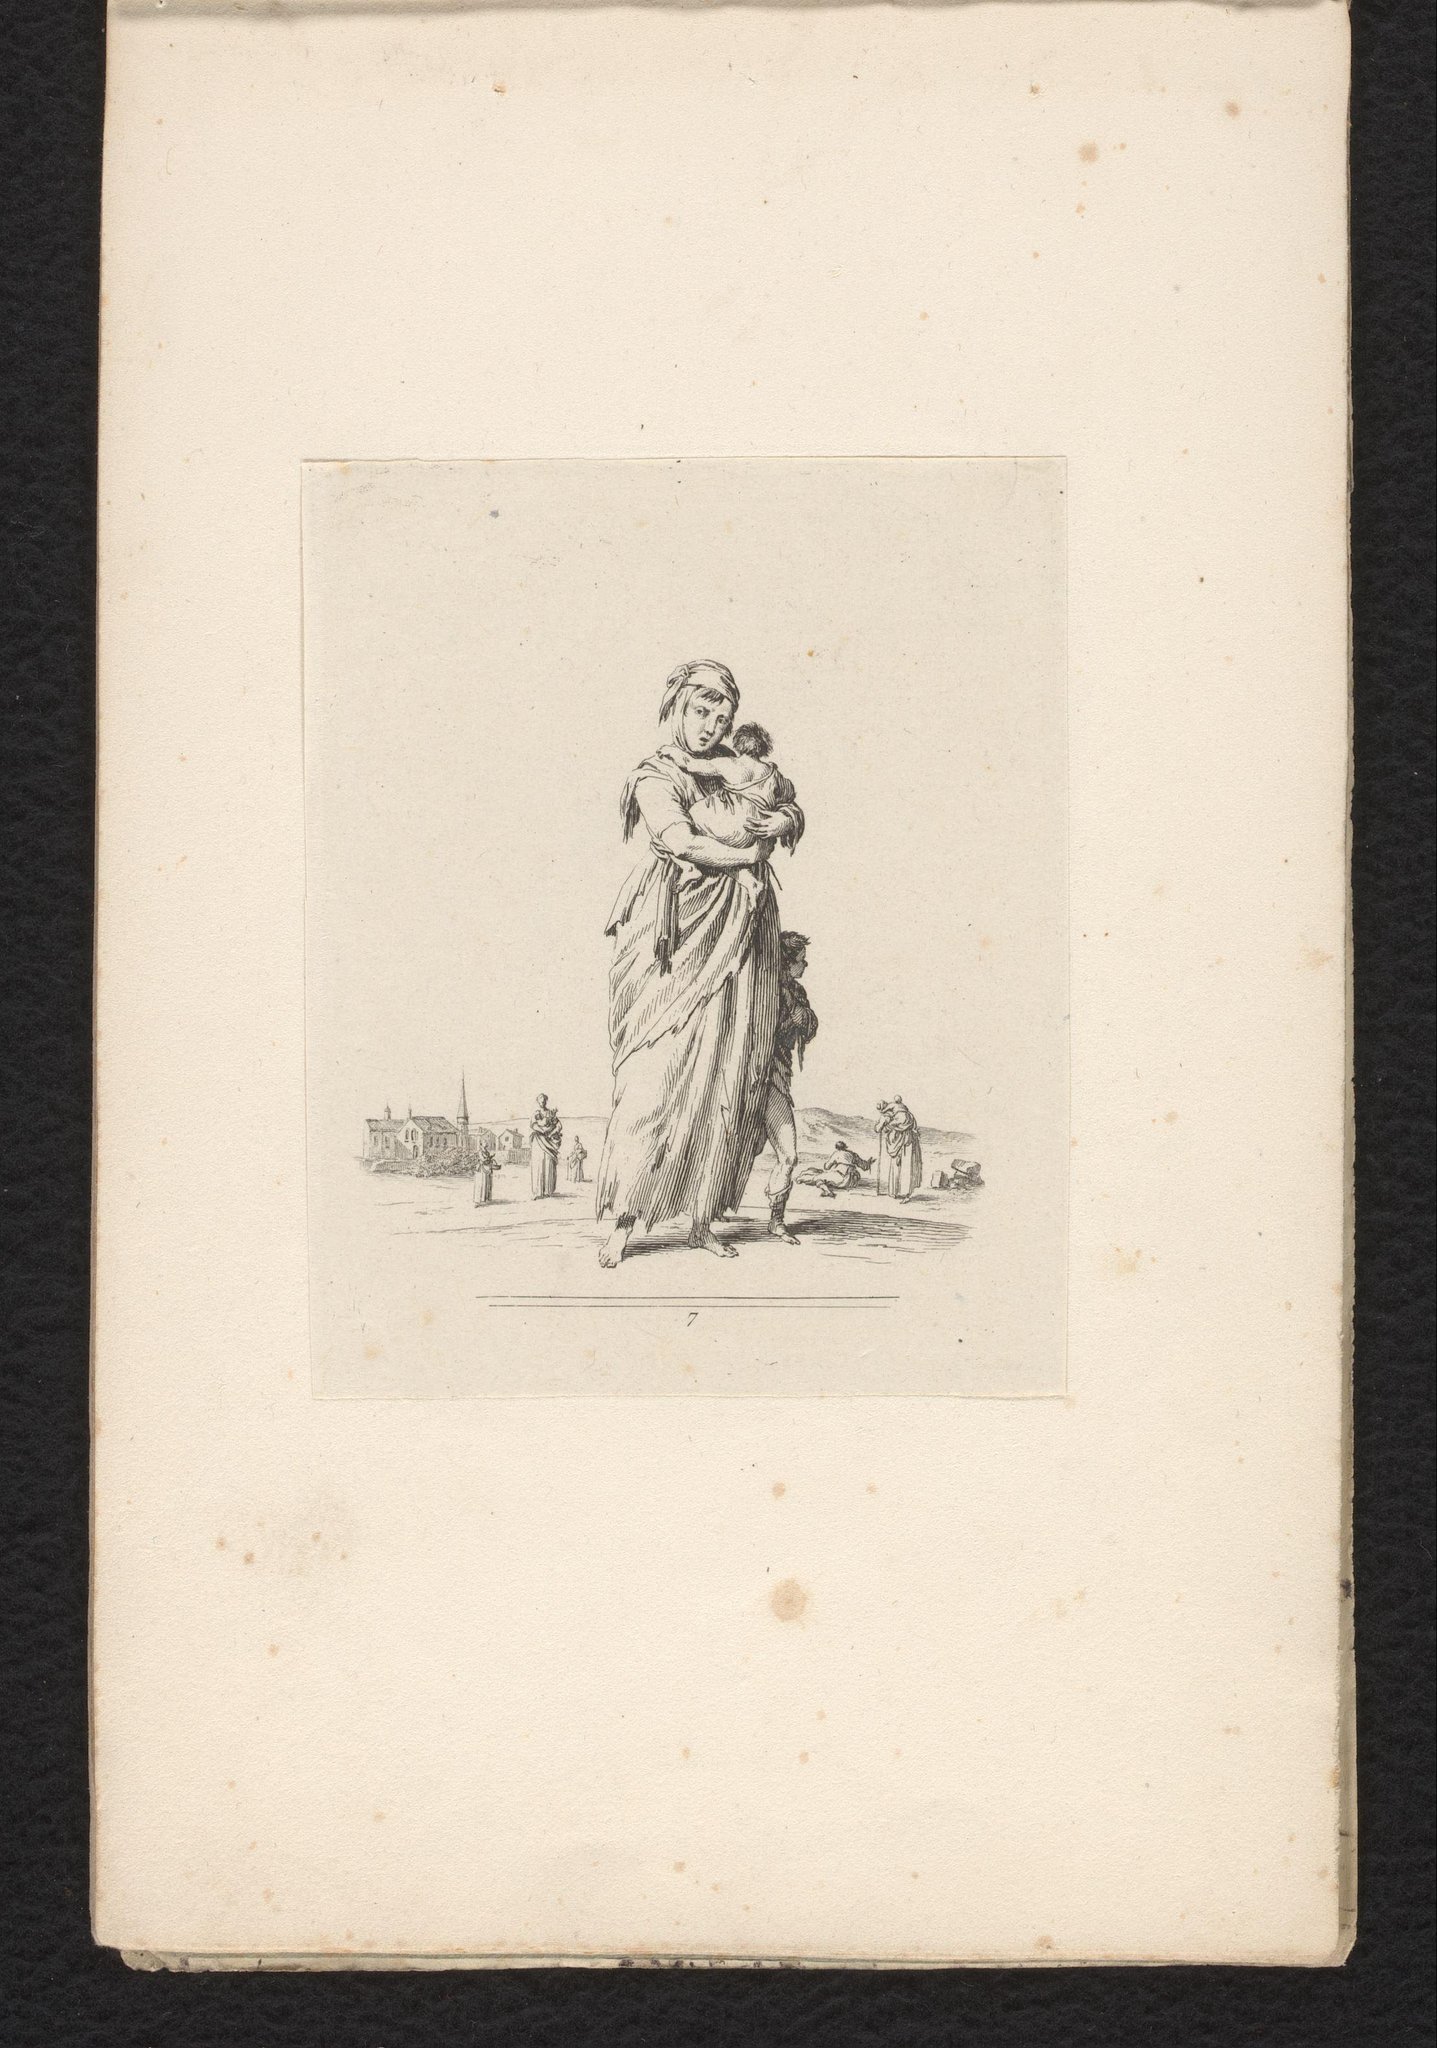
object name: album leaf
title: Bedelares met twee kinderen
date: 1798-1806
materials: paper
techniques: etching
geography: paris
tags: clothed in rags, beggar, mother and child(ren), woman and child(ren) (family group)